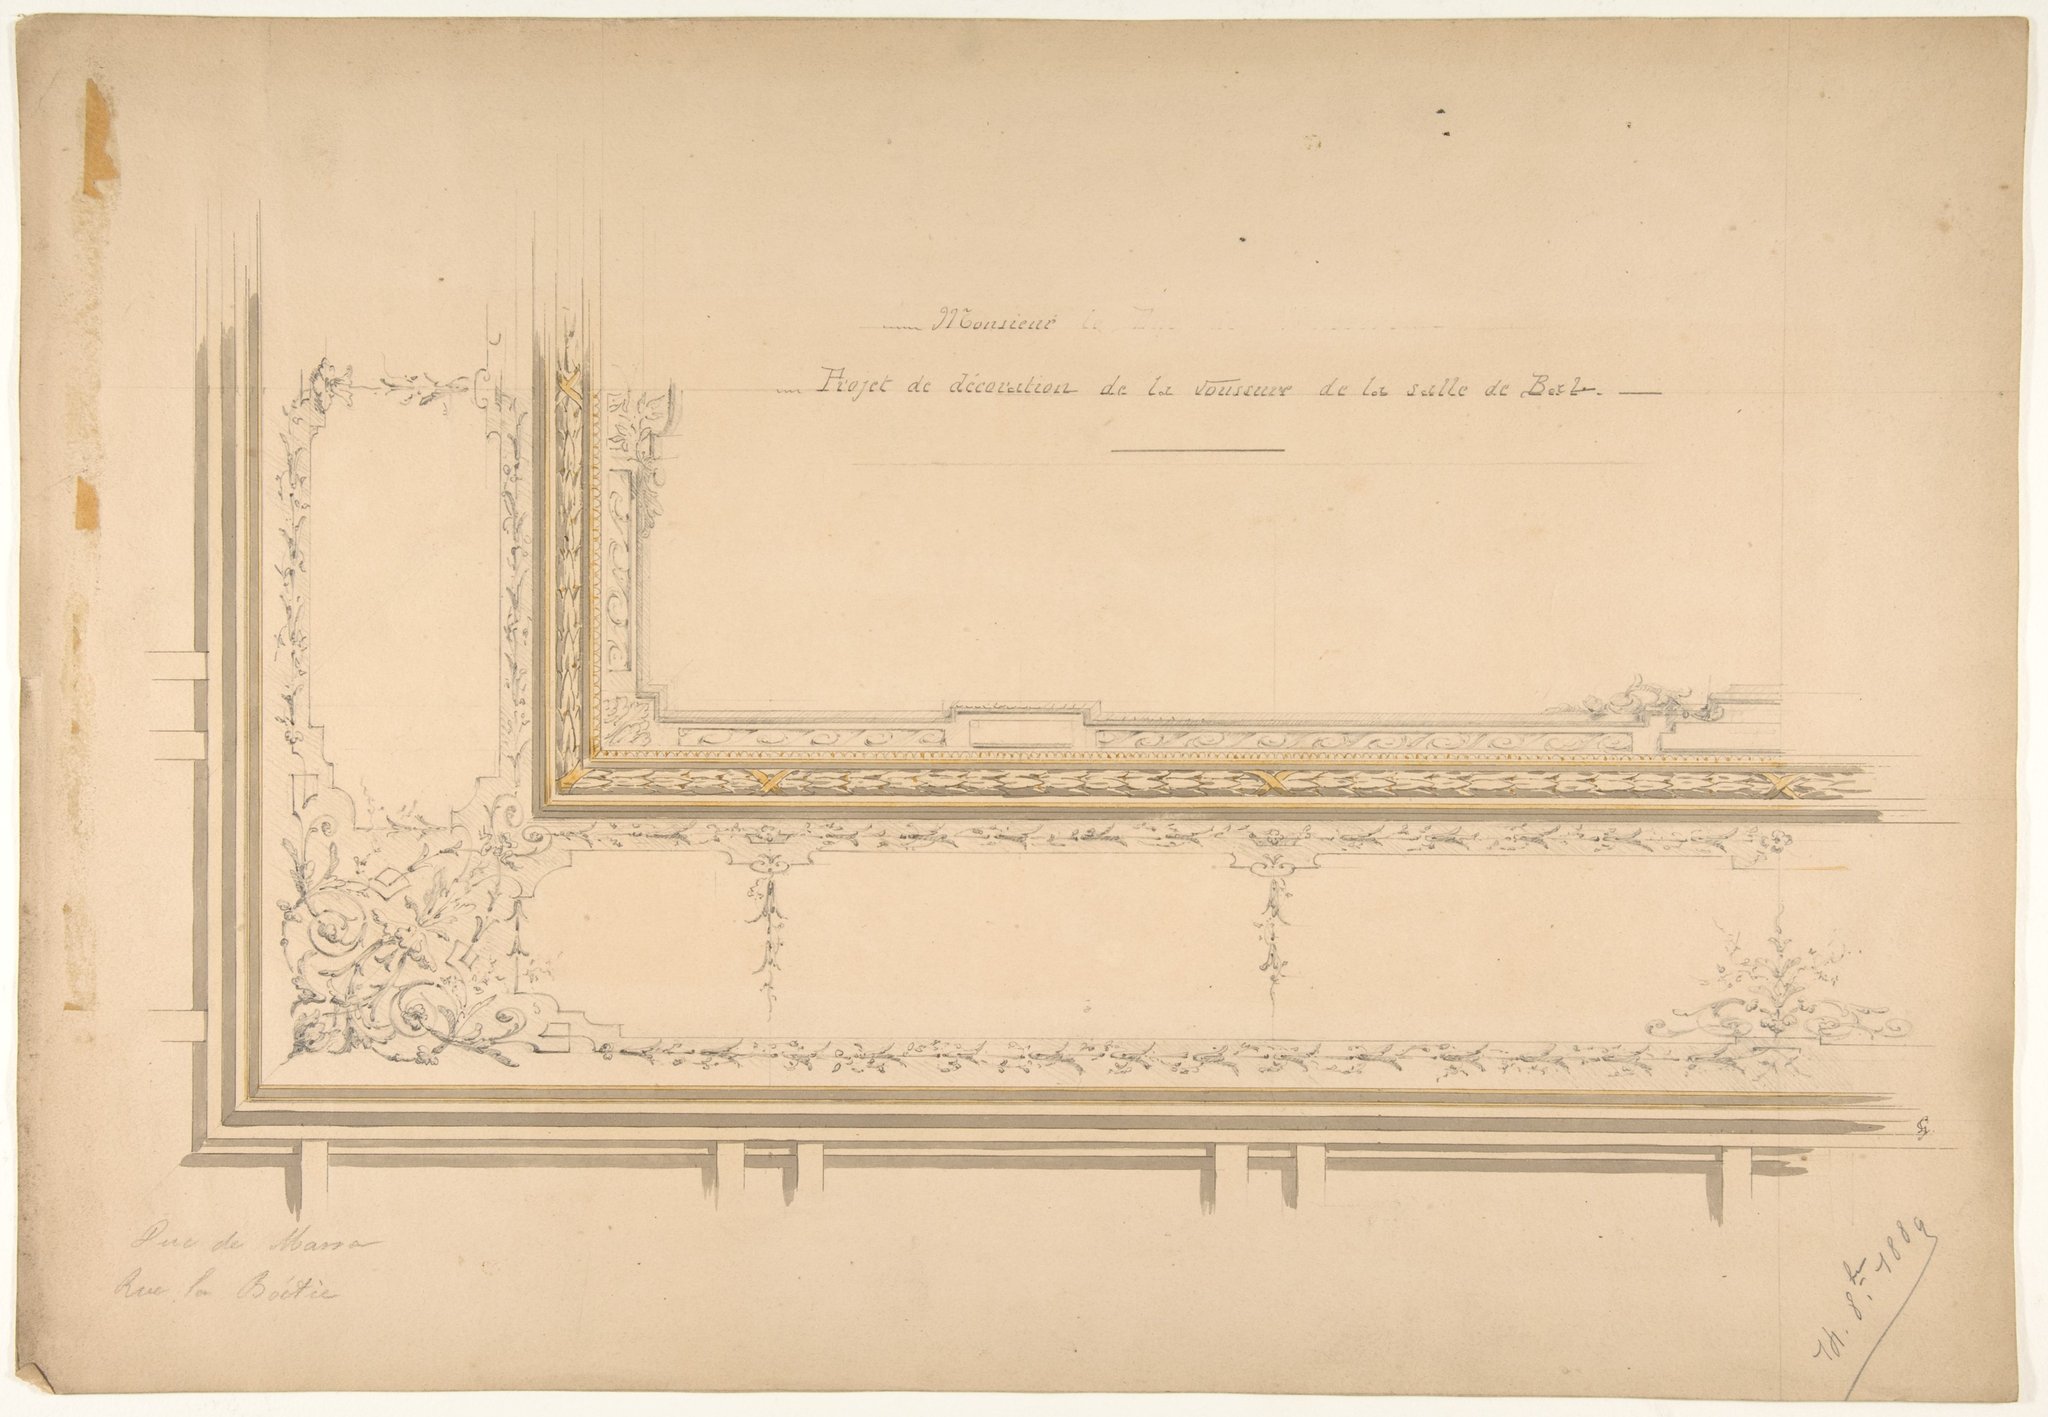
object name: drawing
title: Design for ceiling decoration in the residence of the Duc de Massa on the rue la Boétie, Paris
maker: jules-edmond-charles lachaise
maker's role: artist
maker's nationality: french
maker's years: 1897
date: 1889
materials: graphite, paper, watercolor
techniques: wash